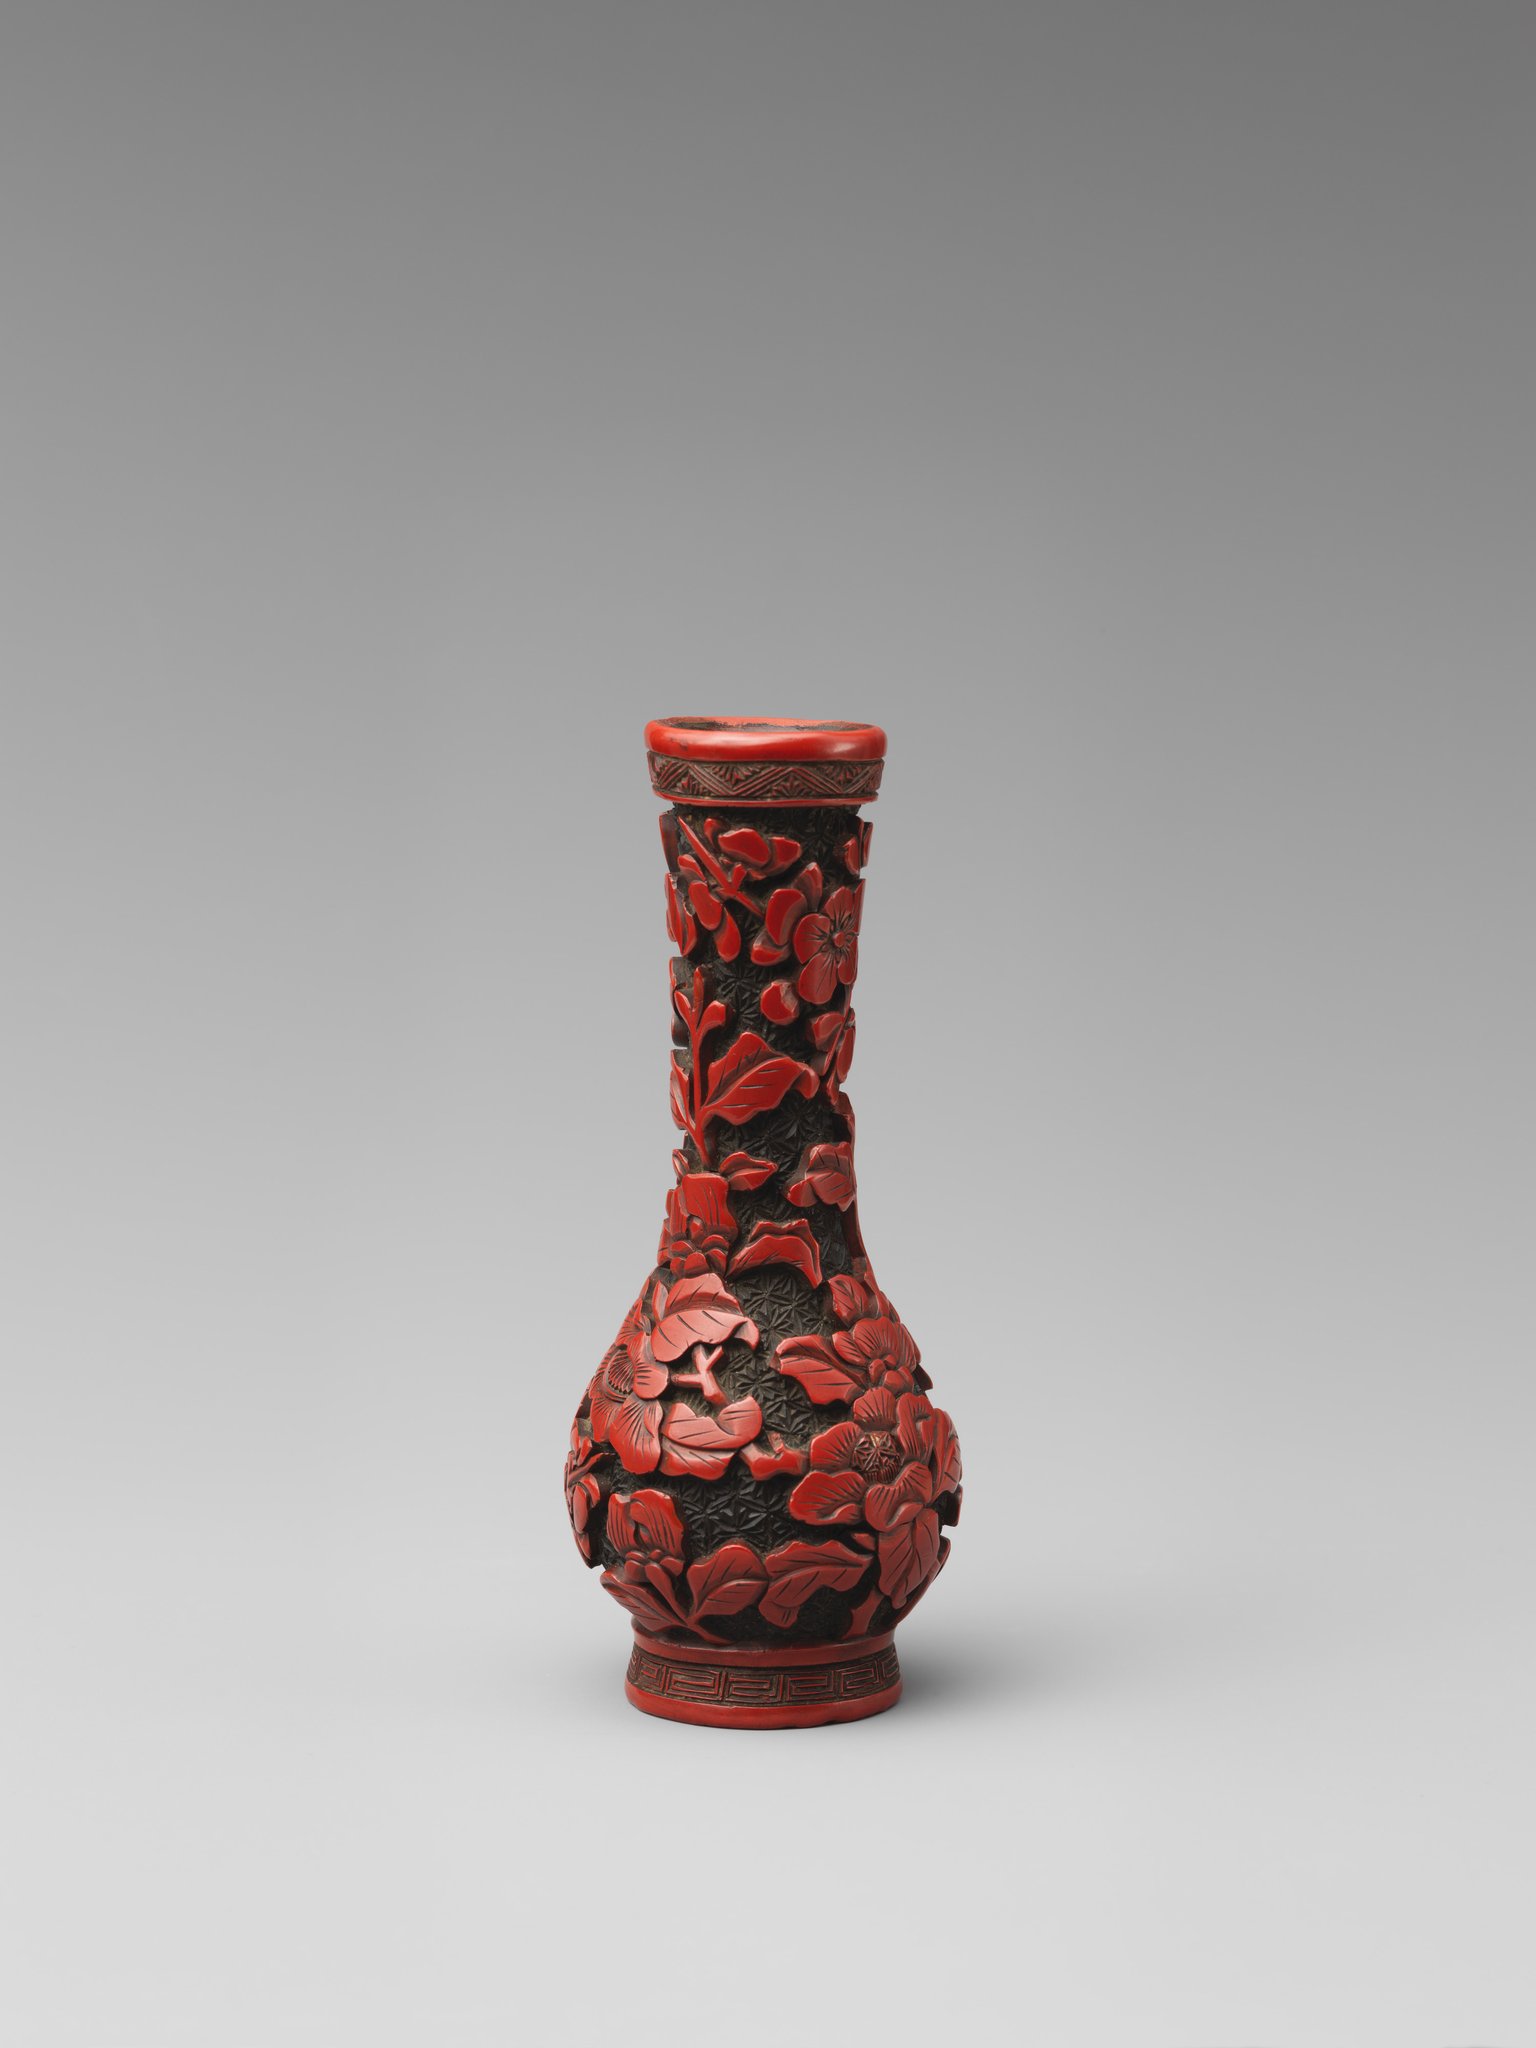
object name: vase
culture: chinese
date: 1701-1800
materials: lacquer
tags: flowers